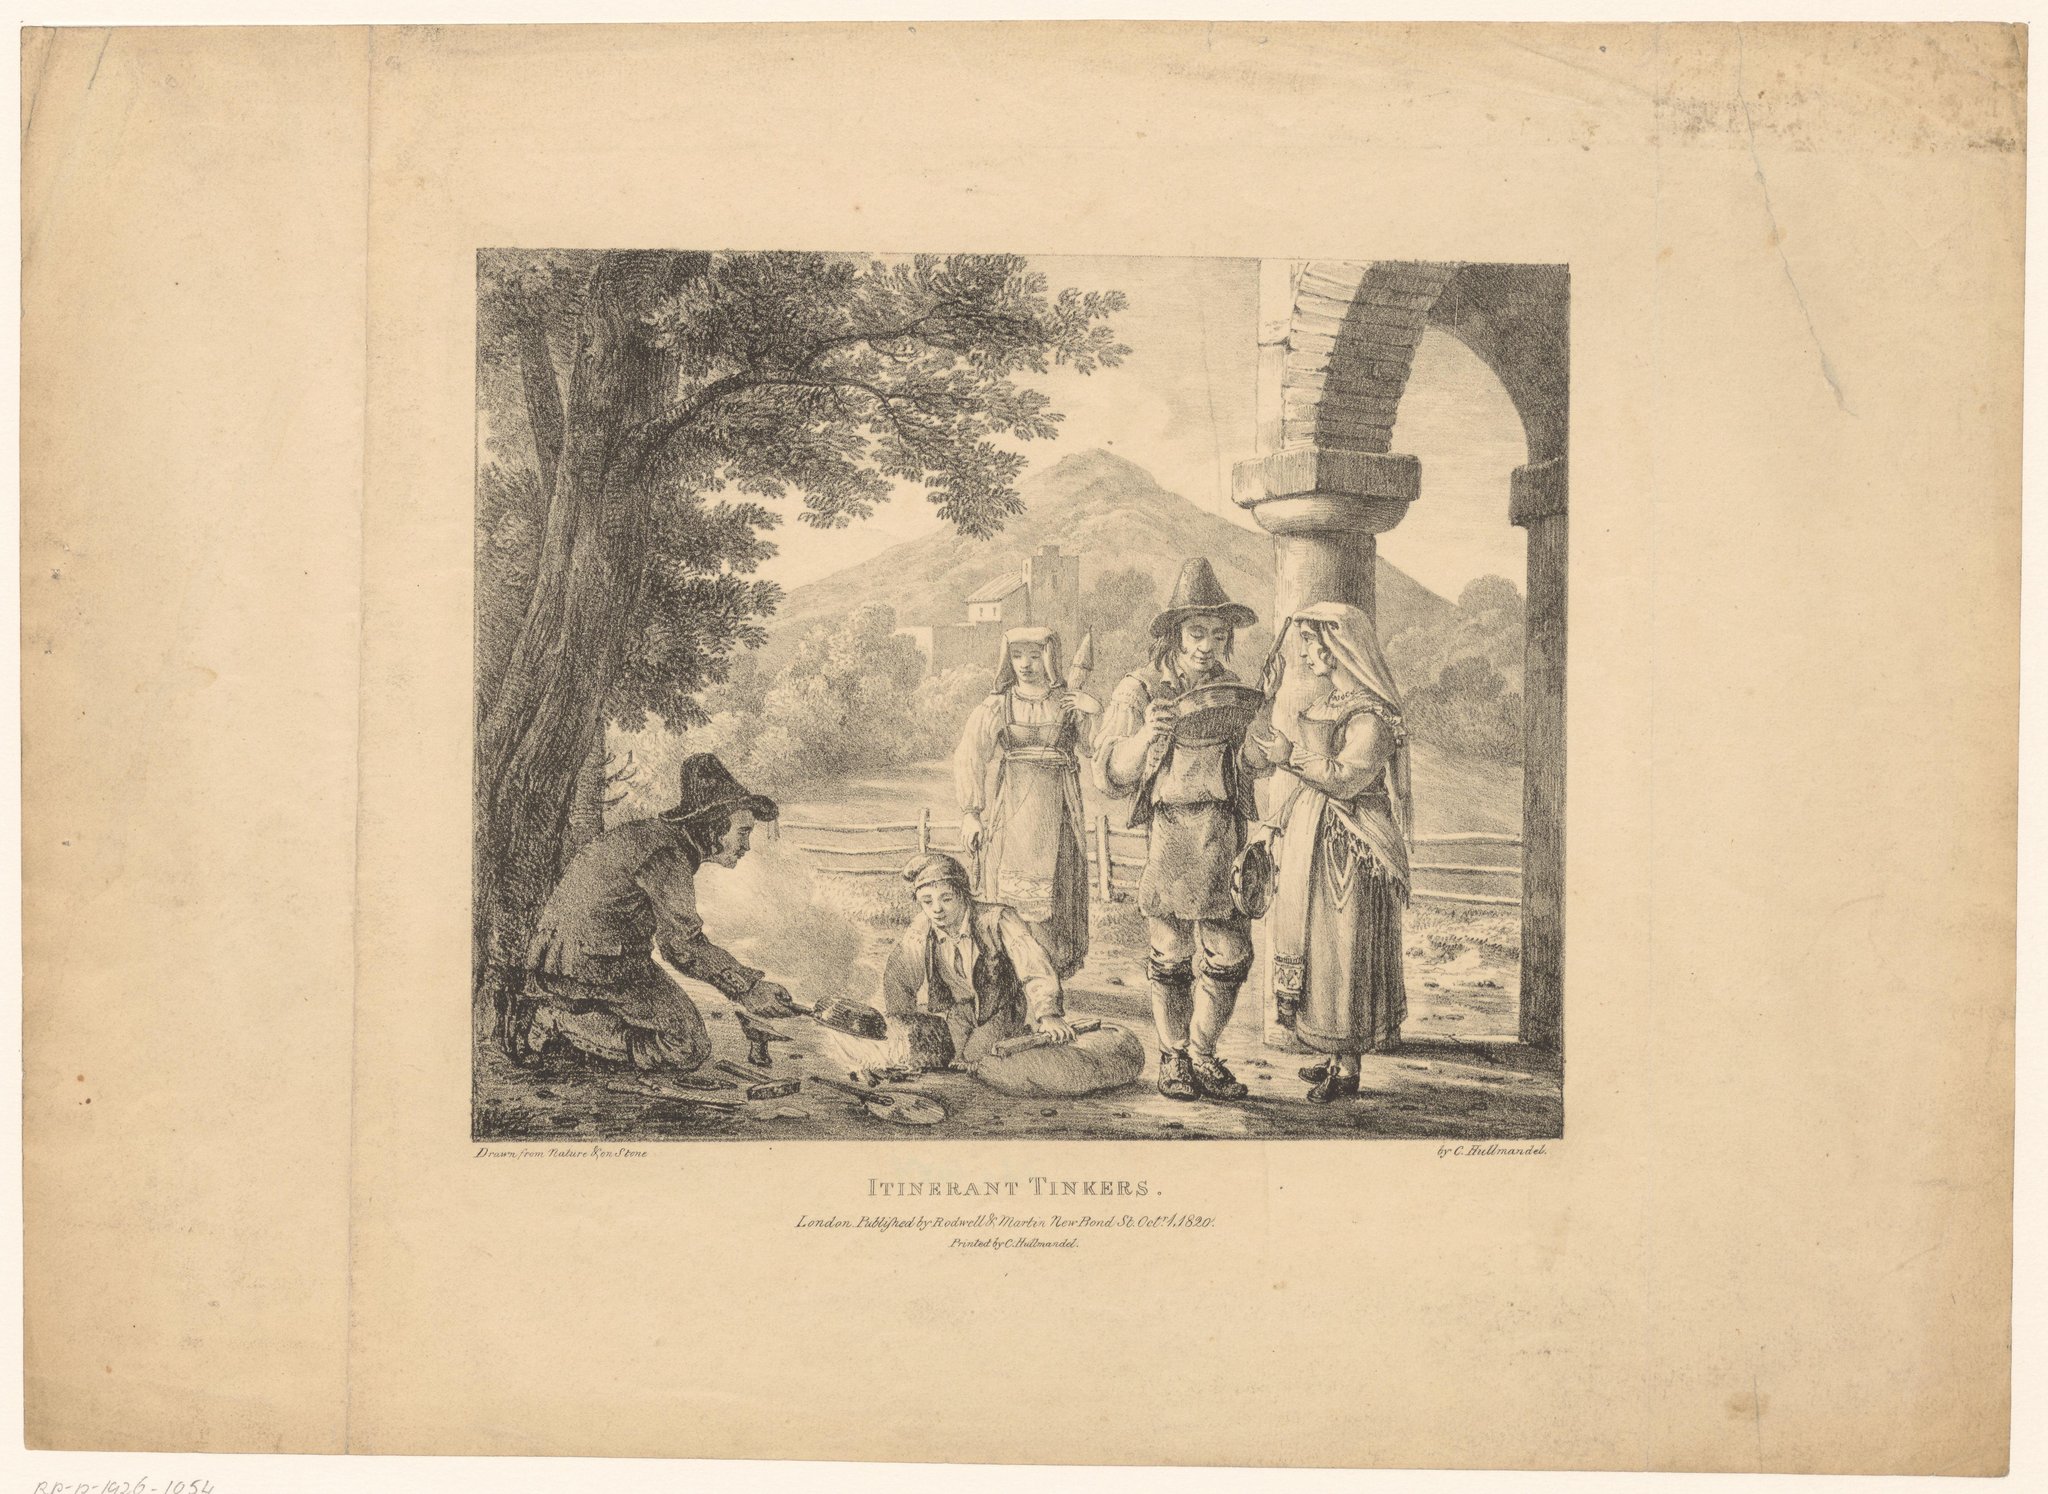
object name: print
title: Itinerant tinkers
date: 1820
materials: paper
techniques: lithograph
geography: london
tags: kitchen-utensils: pan, open fire (in general), landscapes in the temperate zone (+ landscape with figures, staffage)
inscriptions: date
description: De figuren maken of repareren de pannen boven het vuur.